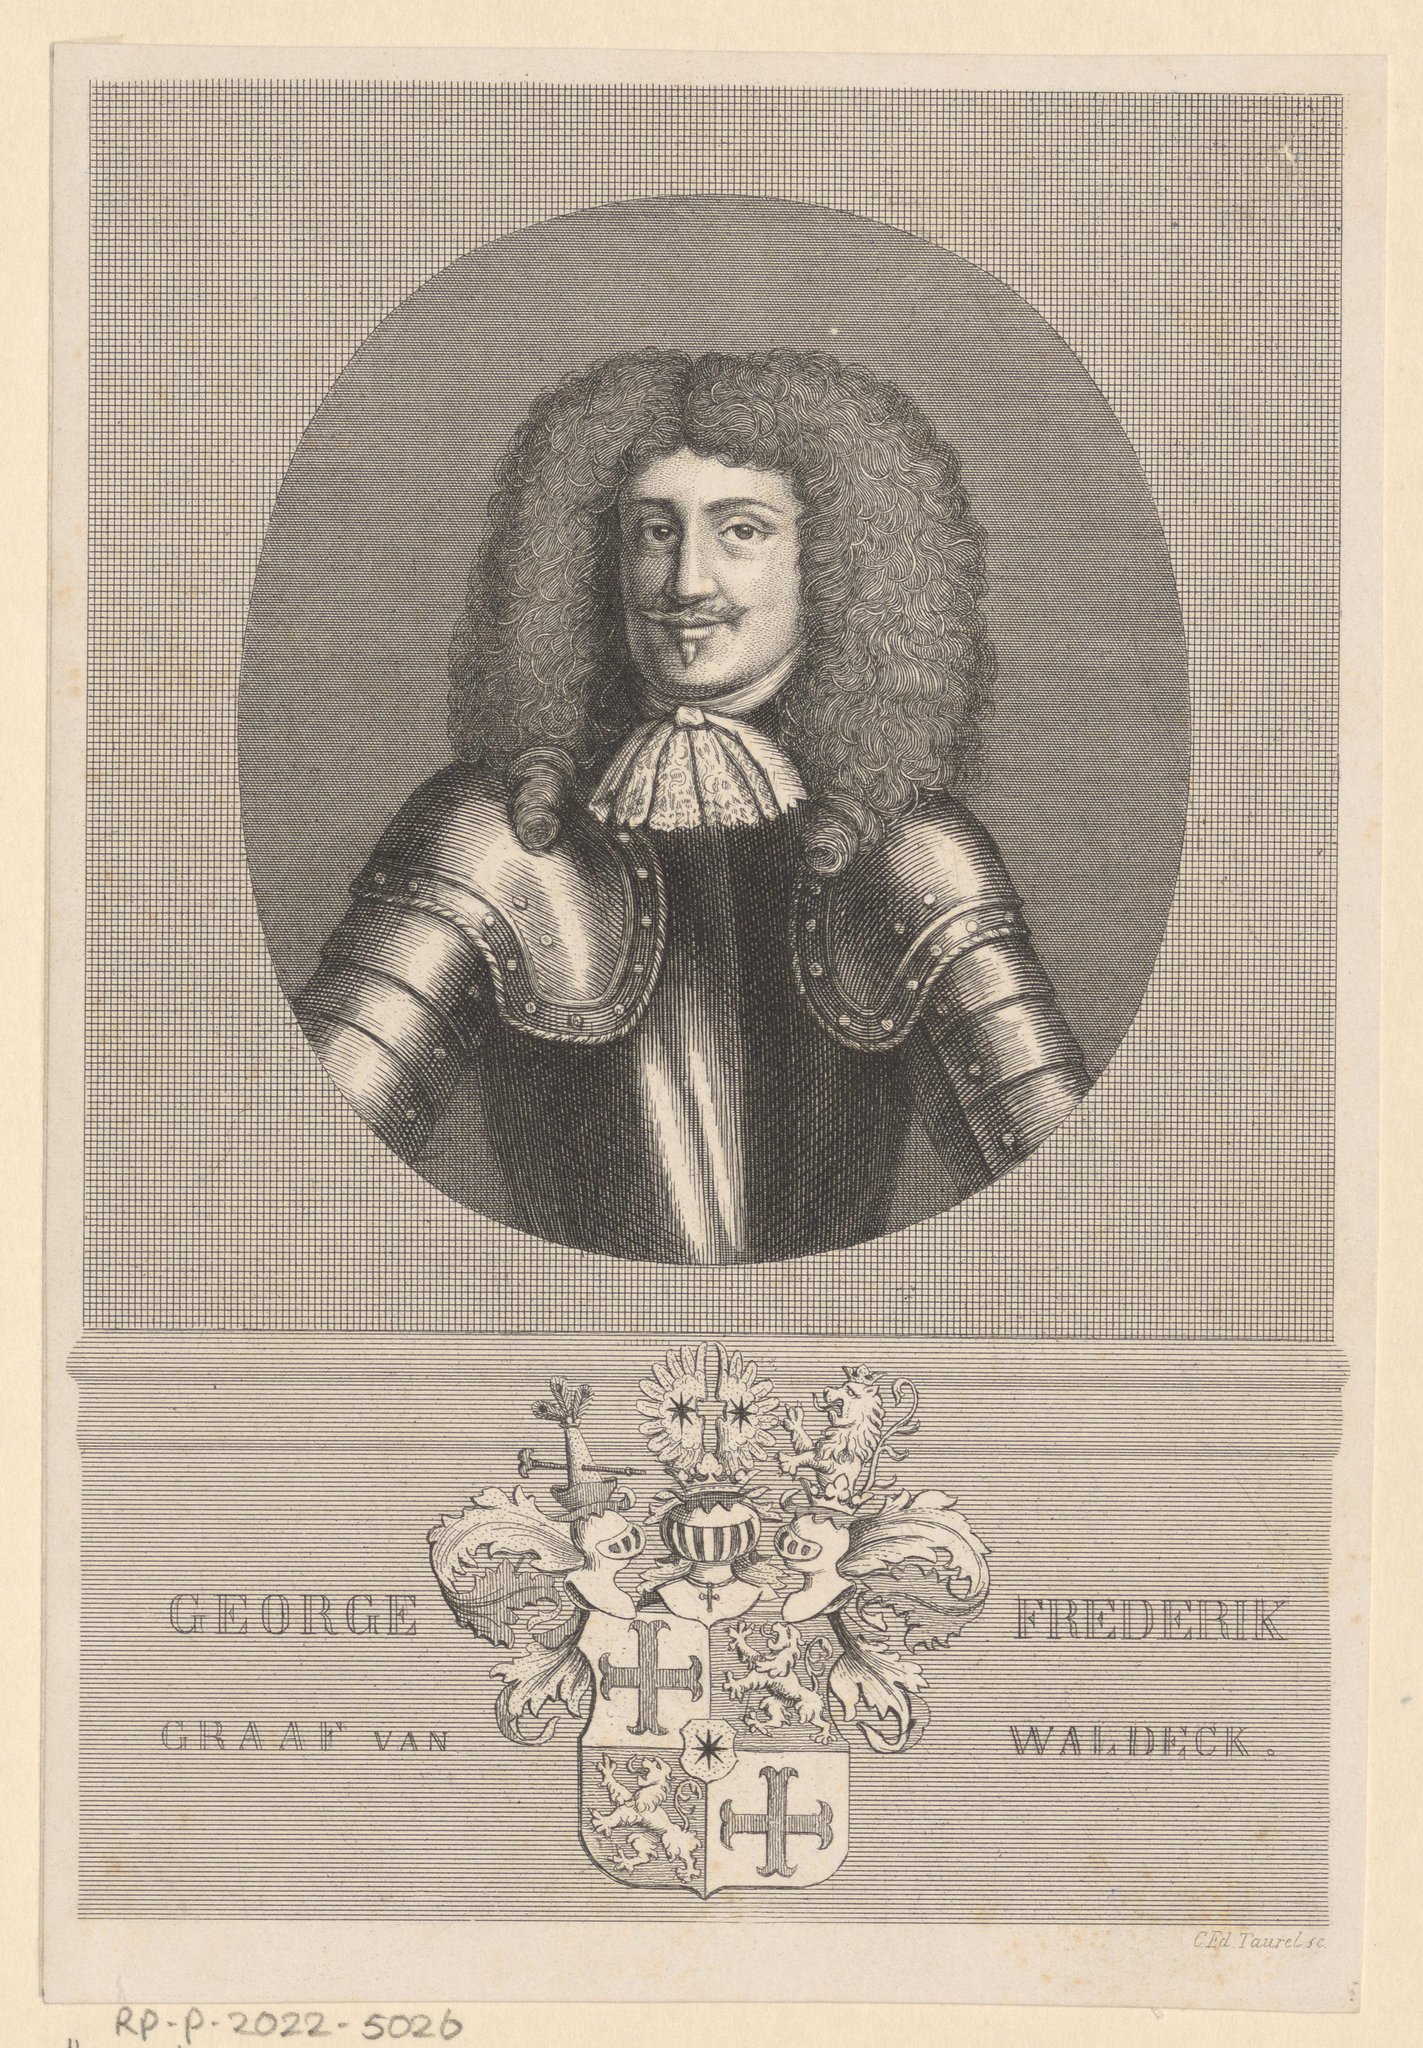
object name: print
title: Portret van Georg Friedrich van Waldeck-Eisenberg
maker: edouard taurel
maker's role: draughtsman, print maker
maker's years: 1824-1892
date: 1879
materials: paper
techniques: engraving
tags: armour, prince, historical persons, armorial bearing, heraldry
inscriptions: number: ‘473’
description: Prent waarschijnlijk uit: Arend, Johannes Pieter, Otto van Rees, Willem Gerard Bril, Johannes Vloten. Algemeene geschiedenis des vaderlands (...). Haarlem: L. de Haan,1879, dl. 4.